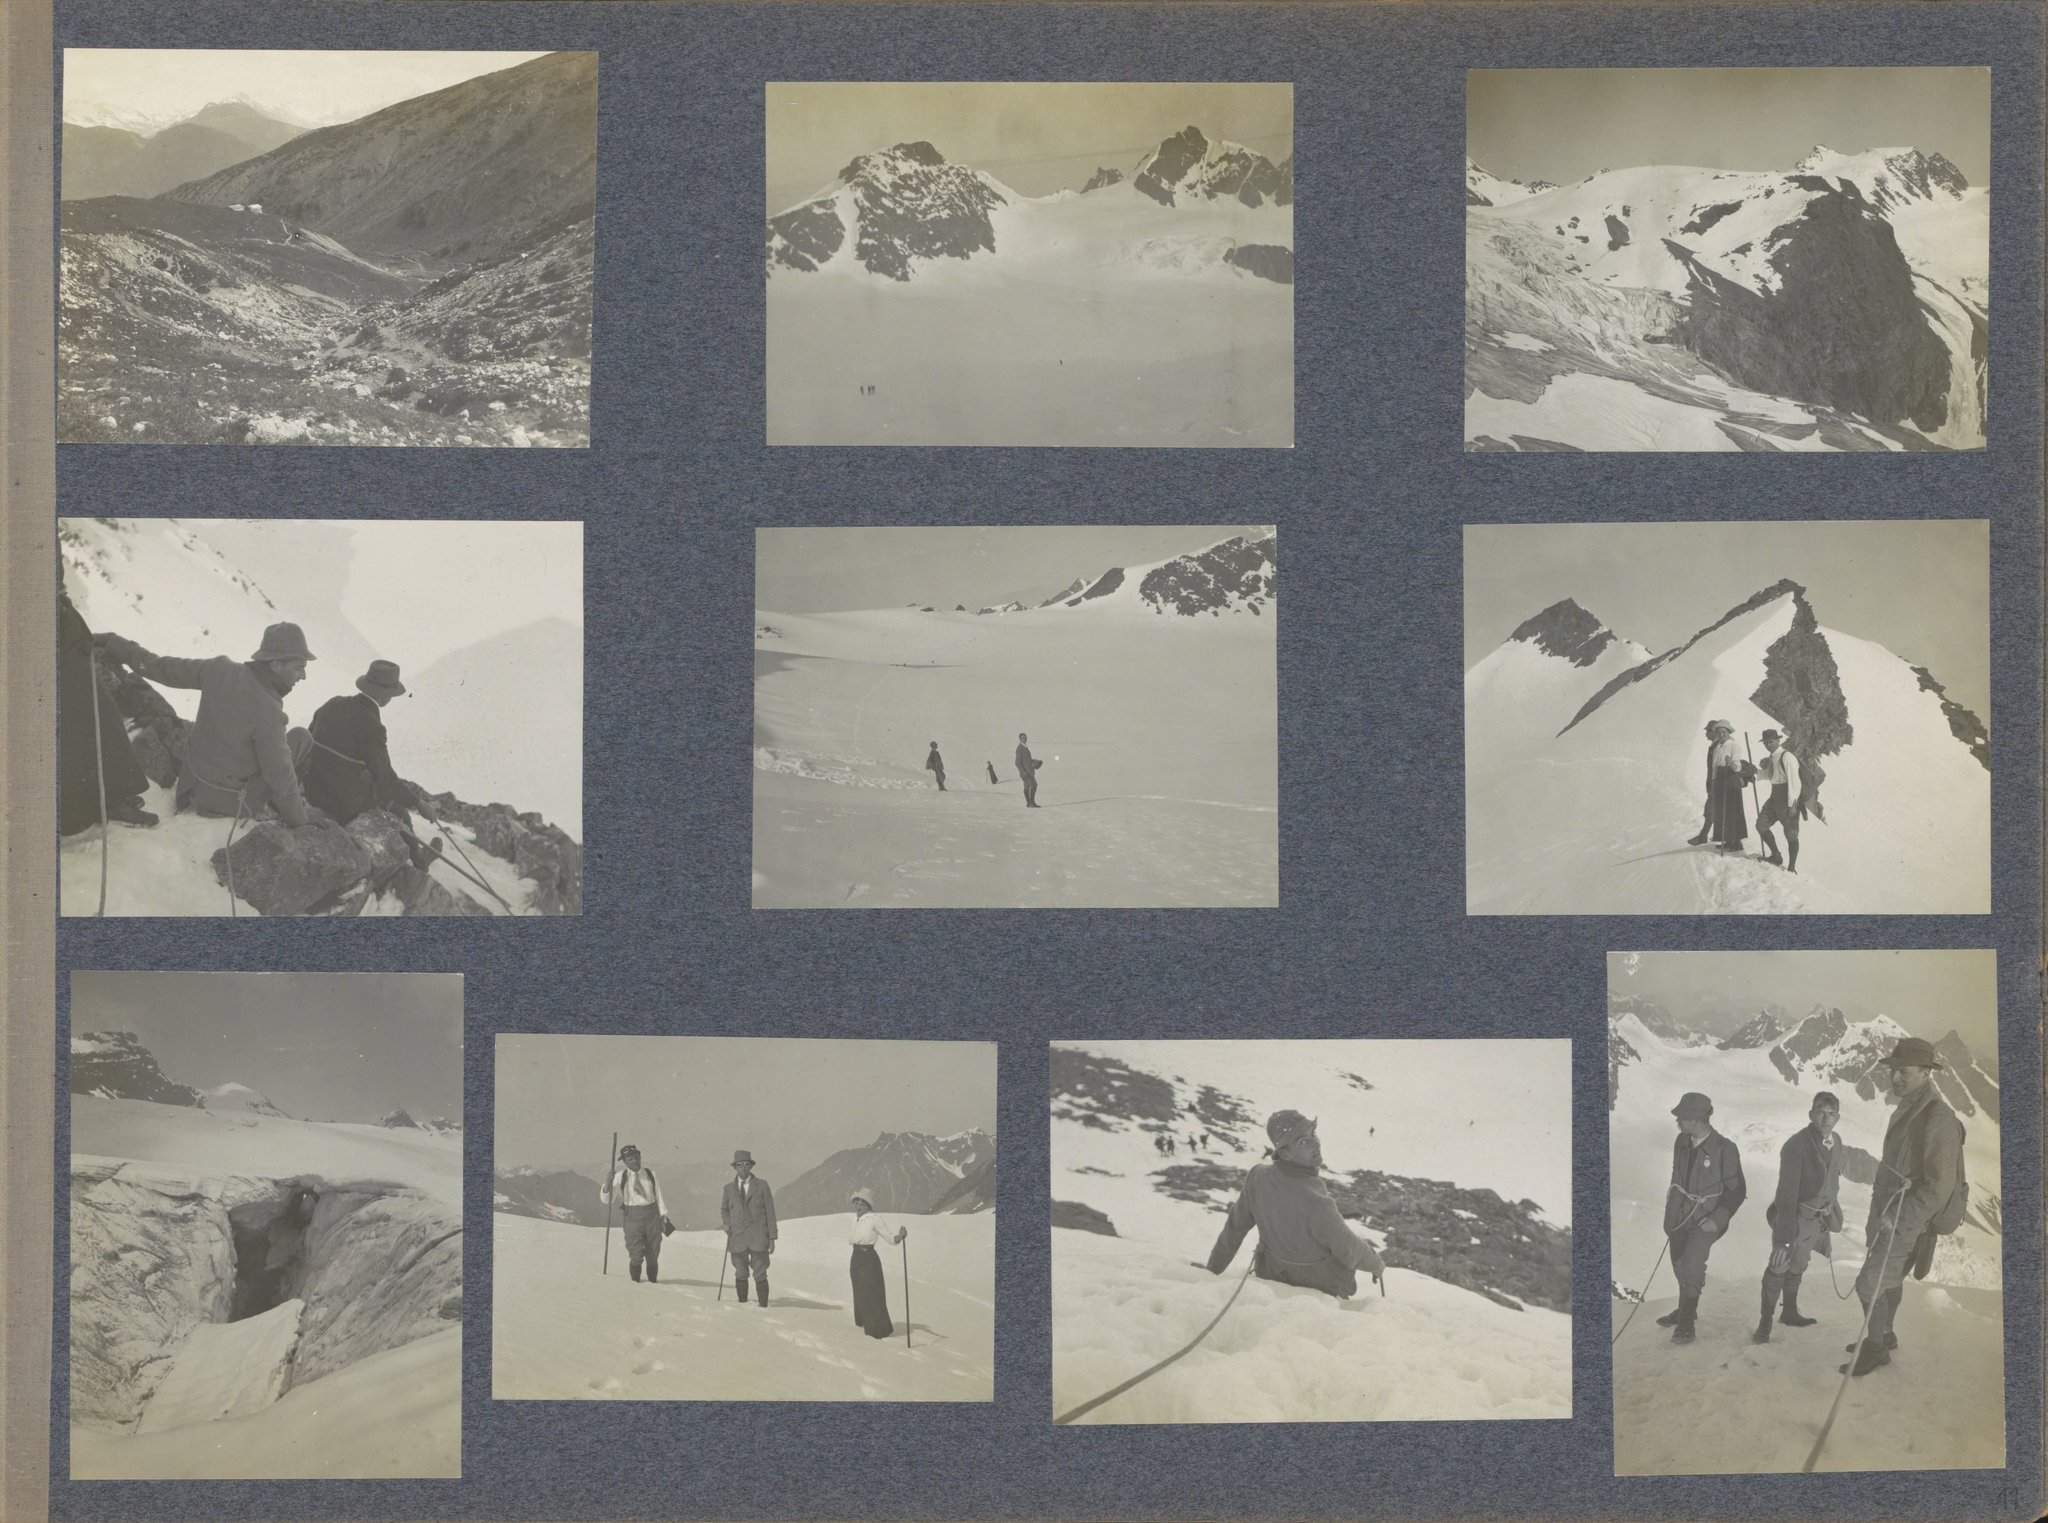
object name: album leaf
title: Verblijf in de bergen (2)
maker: Anonymous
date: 1910-1911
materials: cardboard, paper, photographic support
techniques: gelatin silver print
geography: europe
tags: the family travelling, on holiday, recreation, walking, hiking (recreation), mountain-range, snow peaks, europe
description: Albumblad met tien foto's van een groep mannen en vrouwen tijdens een tocht over besneeuwde berghellingen, mogelijk in Zwitserland of Oostenrijk. Onderdeel van Fotoalbum van de familie Palthe uit Almelo.